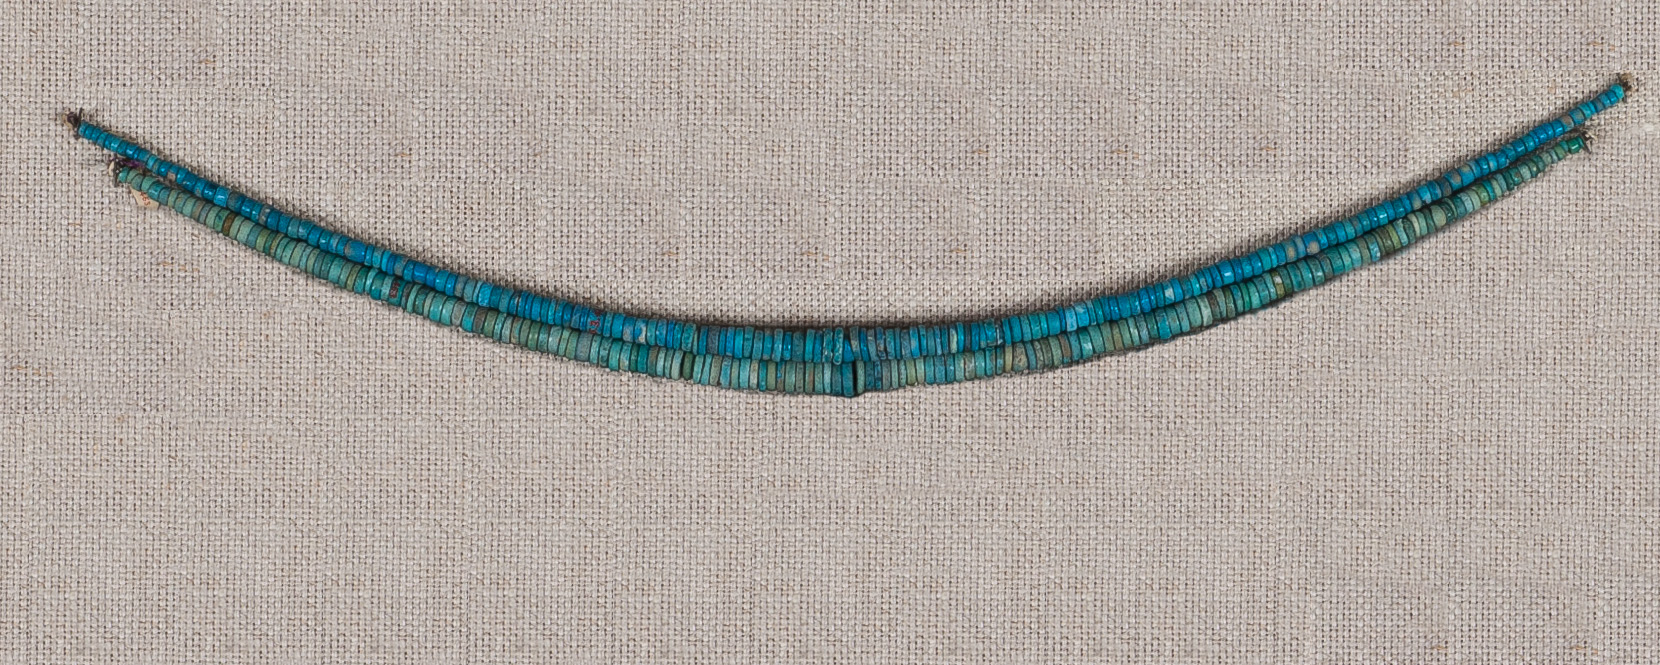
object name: necklace, bead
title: Necklace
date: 1981-1295 BCE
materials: faience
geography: egypt